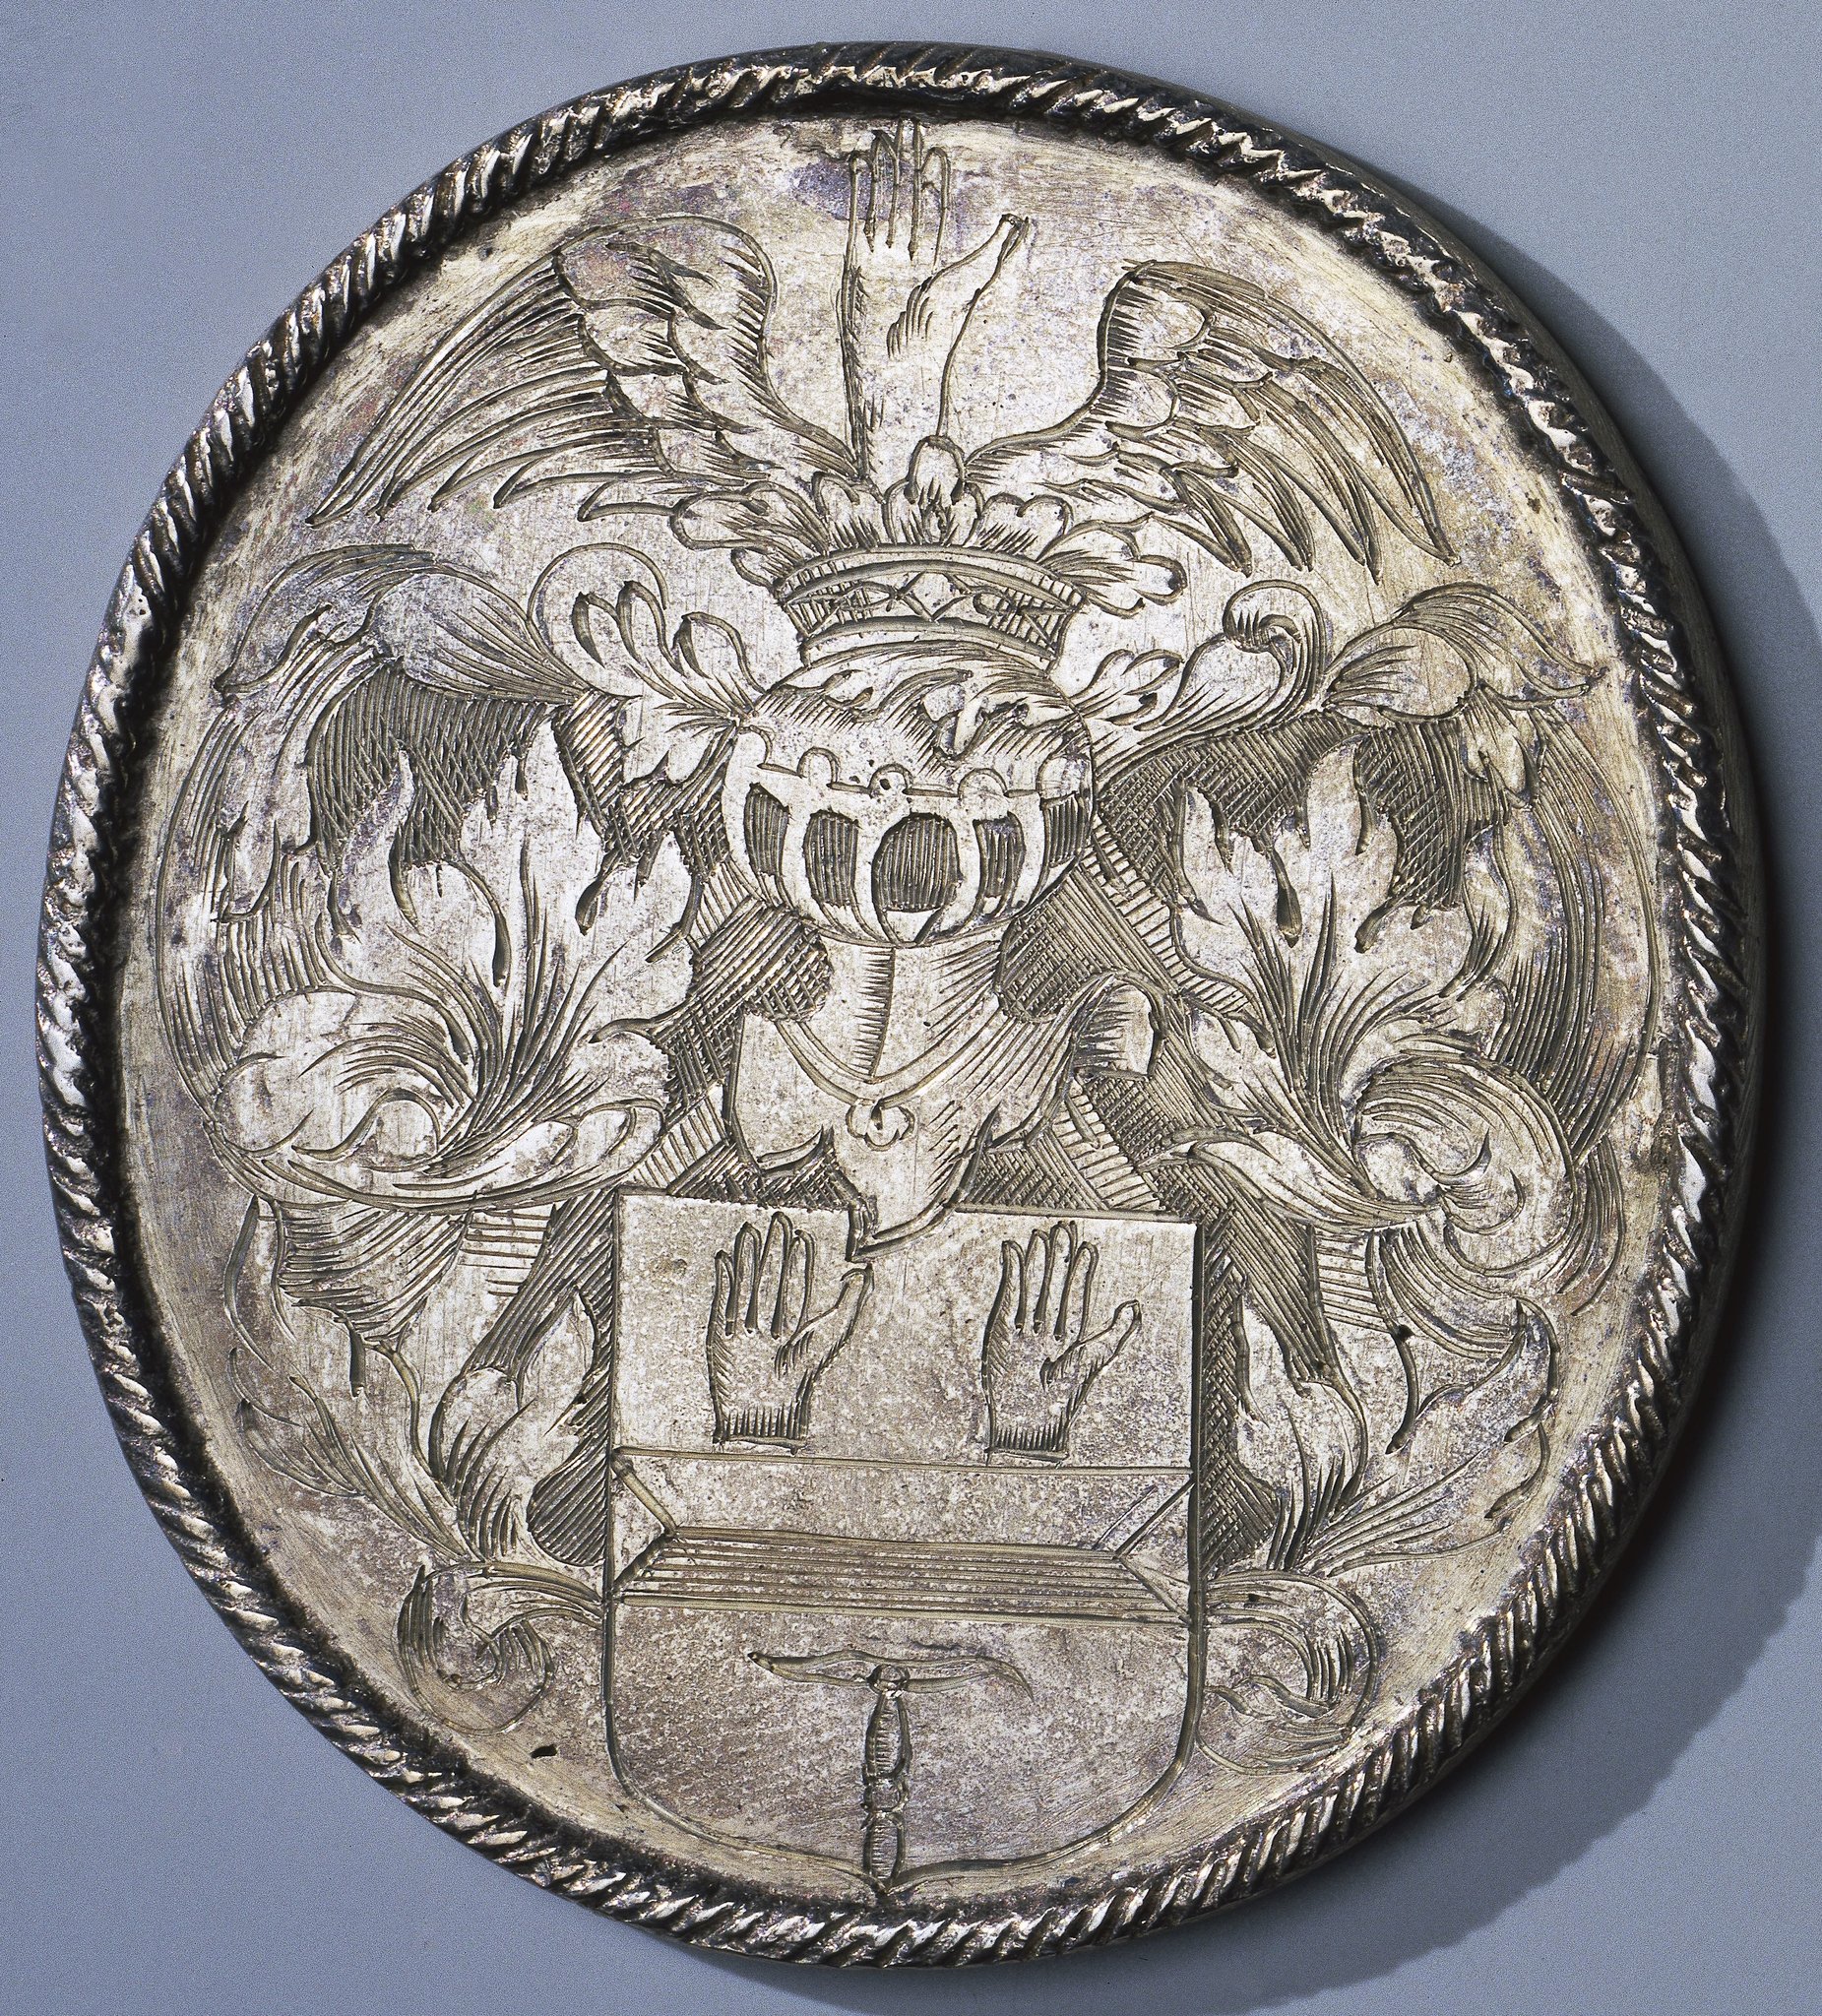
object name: overlijdenspenning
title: Overlijden van Cornelis Speelman, gouverneur-generaal van Nederlands-Indië, Batavia, 11 januari 1684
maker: Anonymous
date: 1684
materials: silver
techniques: engraving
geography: batavia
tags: rotterdam, batavia, colonial governor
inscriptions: inscription: ‘Ter Gedachtenis VAN D.E.D. Heer CORNELIS SPEELMAN Gouverneur Generaal VAN HET NEDERLANDS INDIA Geboren tot Rotterdam den 3 Maart 1628 Overleden tot Batavia Den 11 jan 1684’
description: Medallion. Made in Batavia in 1684 to mark the death of Governor General Cornelis Speelman (1628-1684).